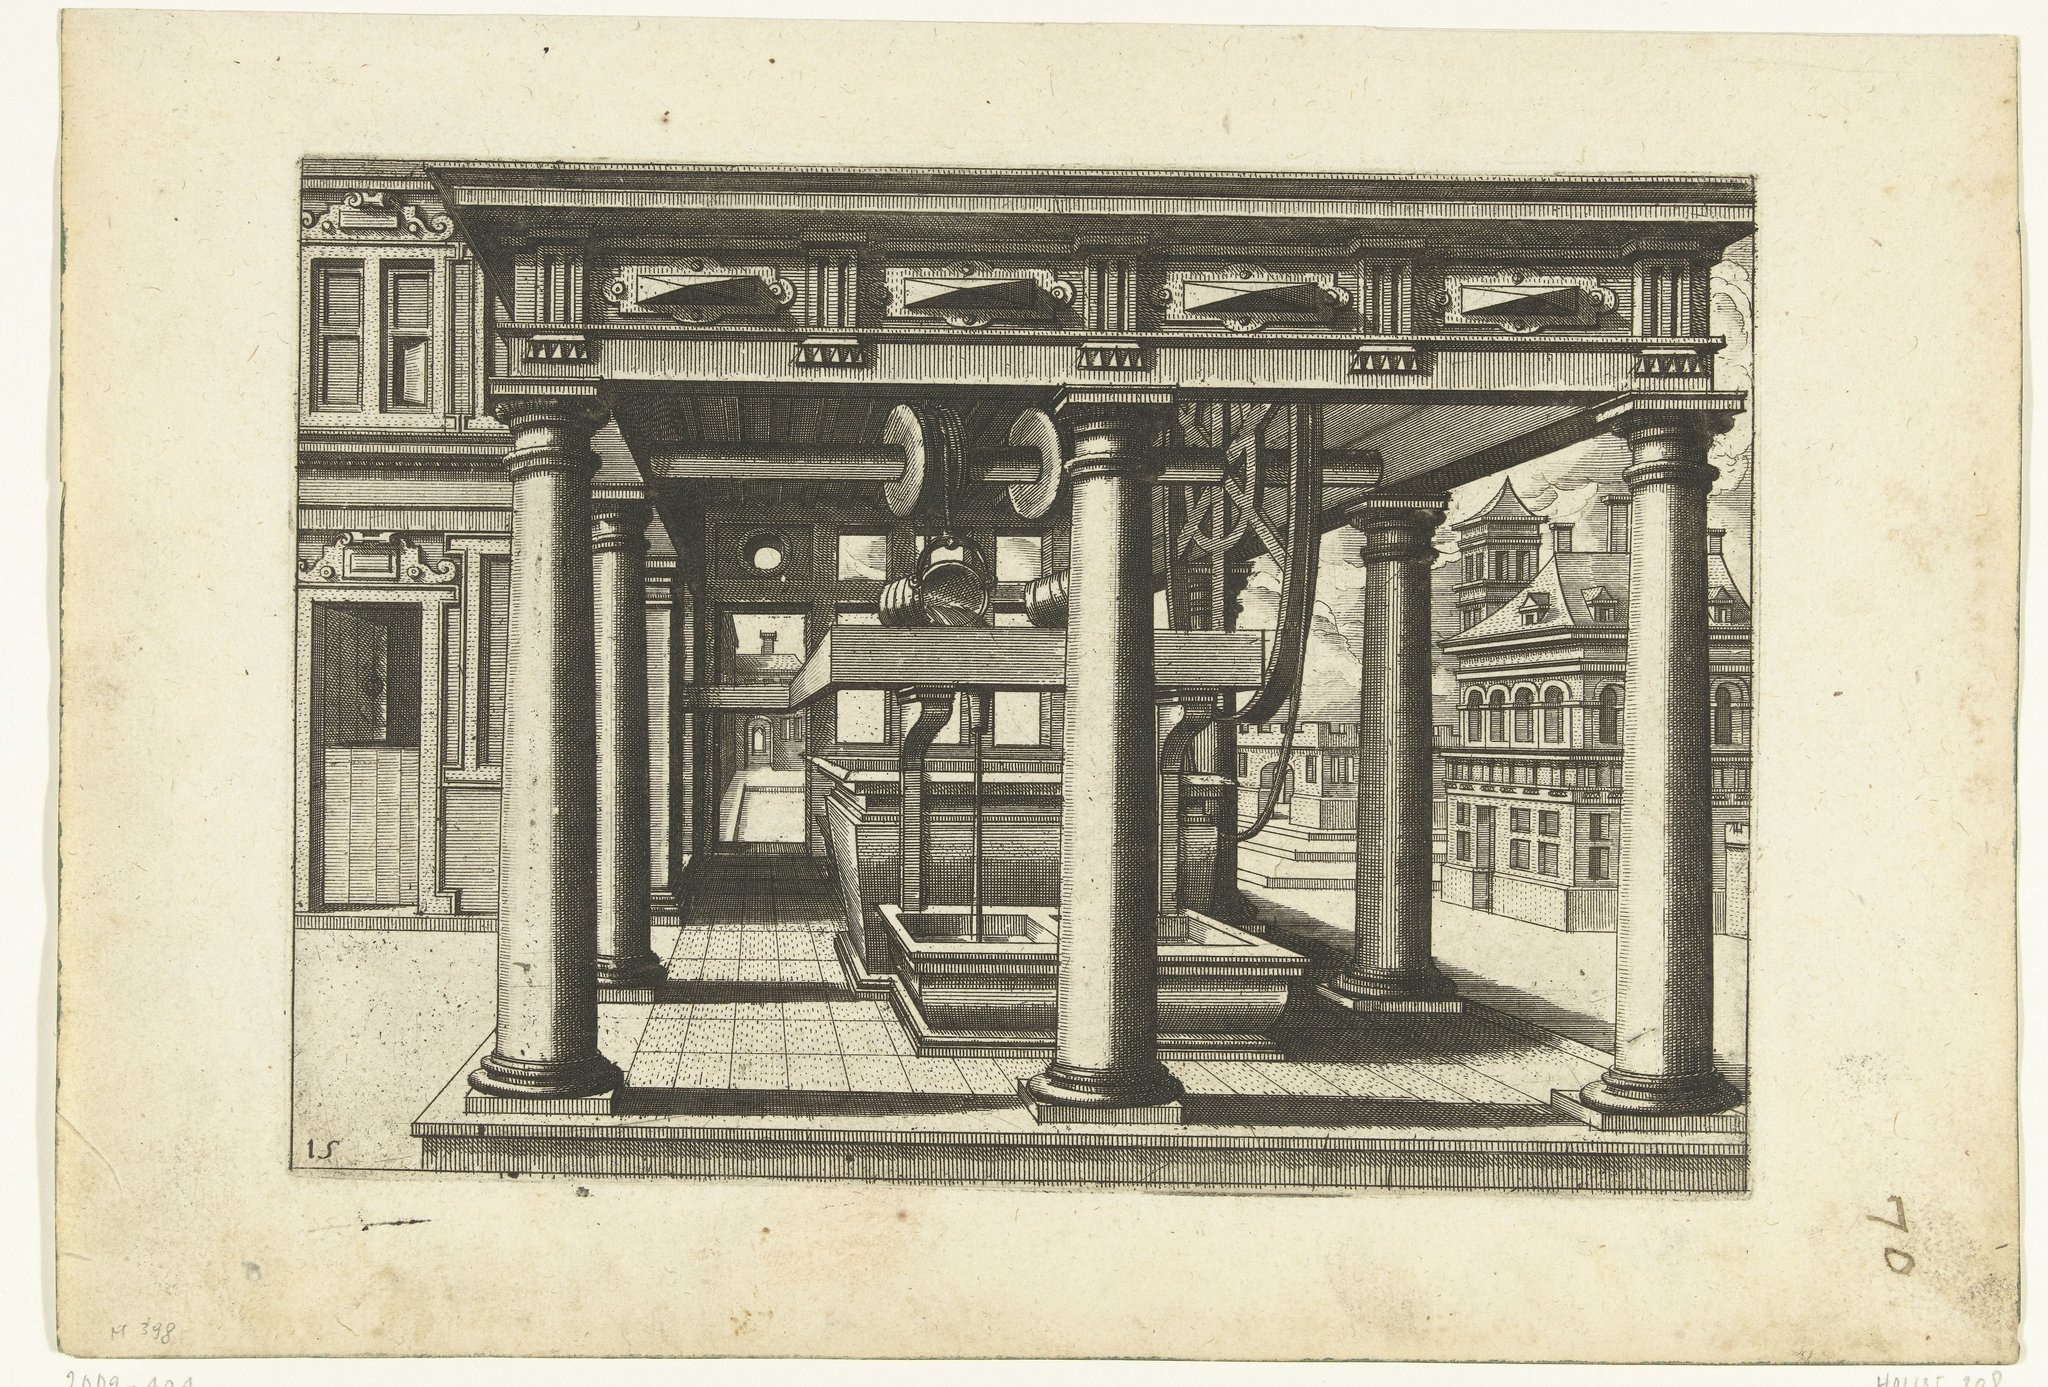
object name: ornament print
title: Waterputten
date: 1574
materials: paper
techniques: etching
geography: antwerp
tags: well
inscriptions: number: ‘15’, inscription: ‘70’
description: Onder een kolonnade met Toscaanse zuilen een rechthoekige waterput. Rechts gezicht op een stadsplein. No. 15 uit serie van 24 kleine waterputten